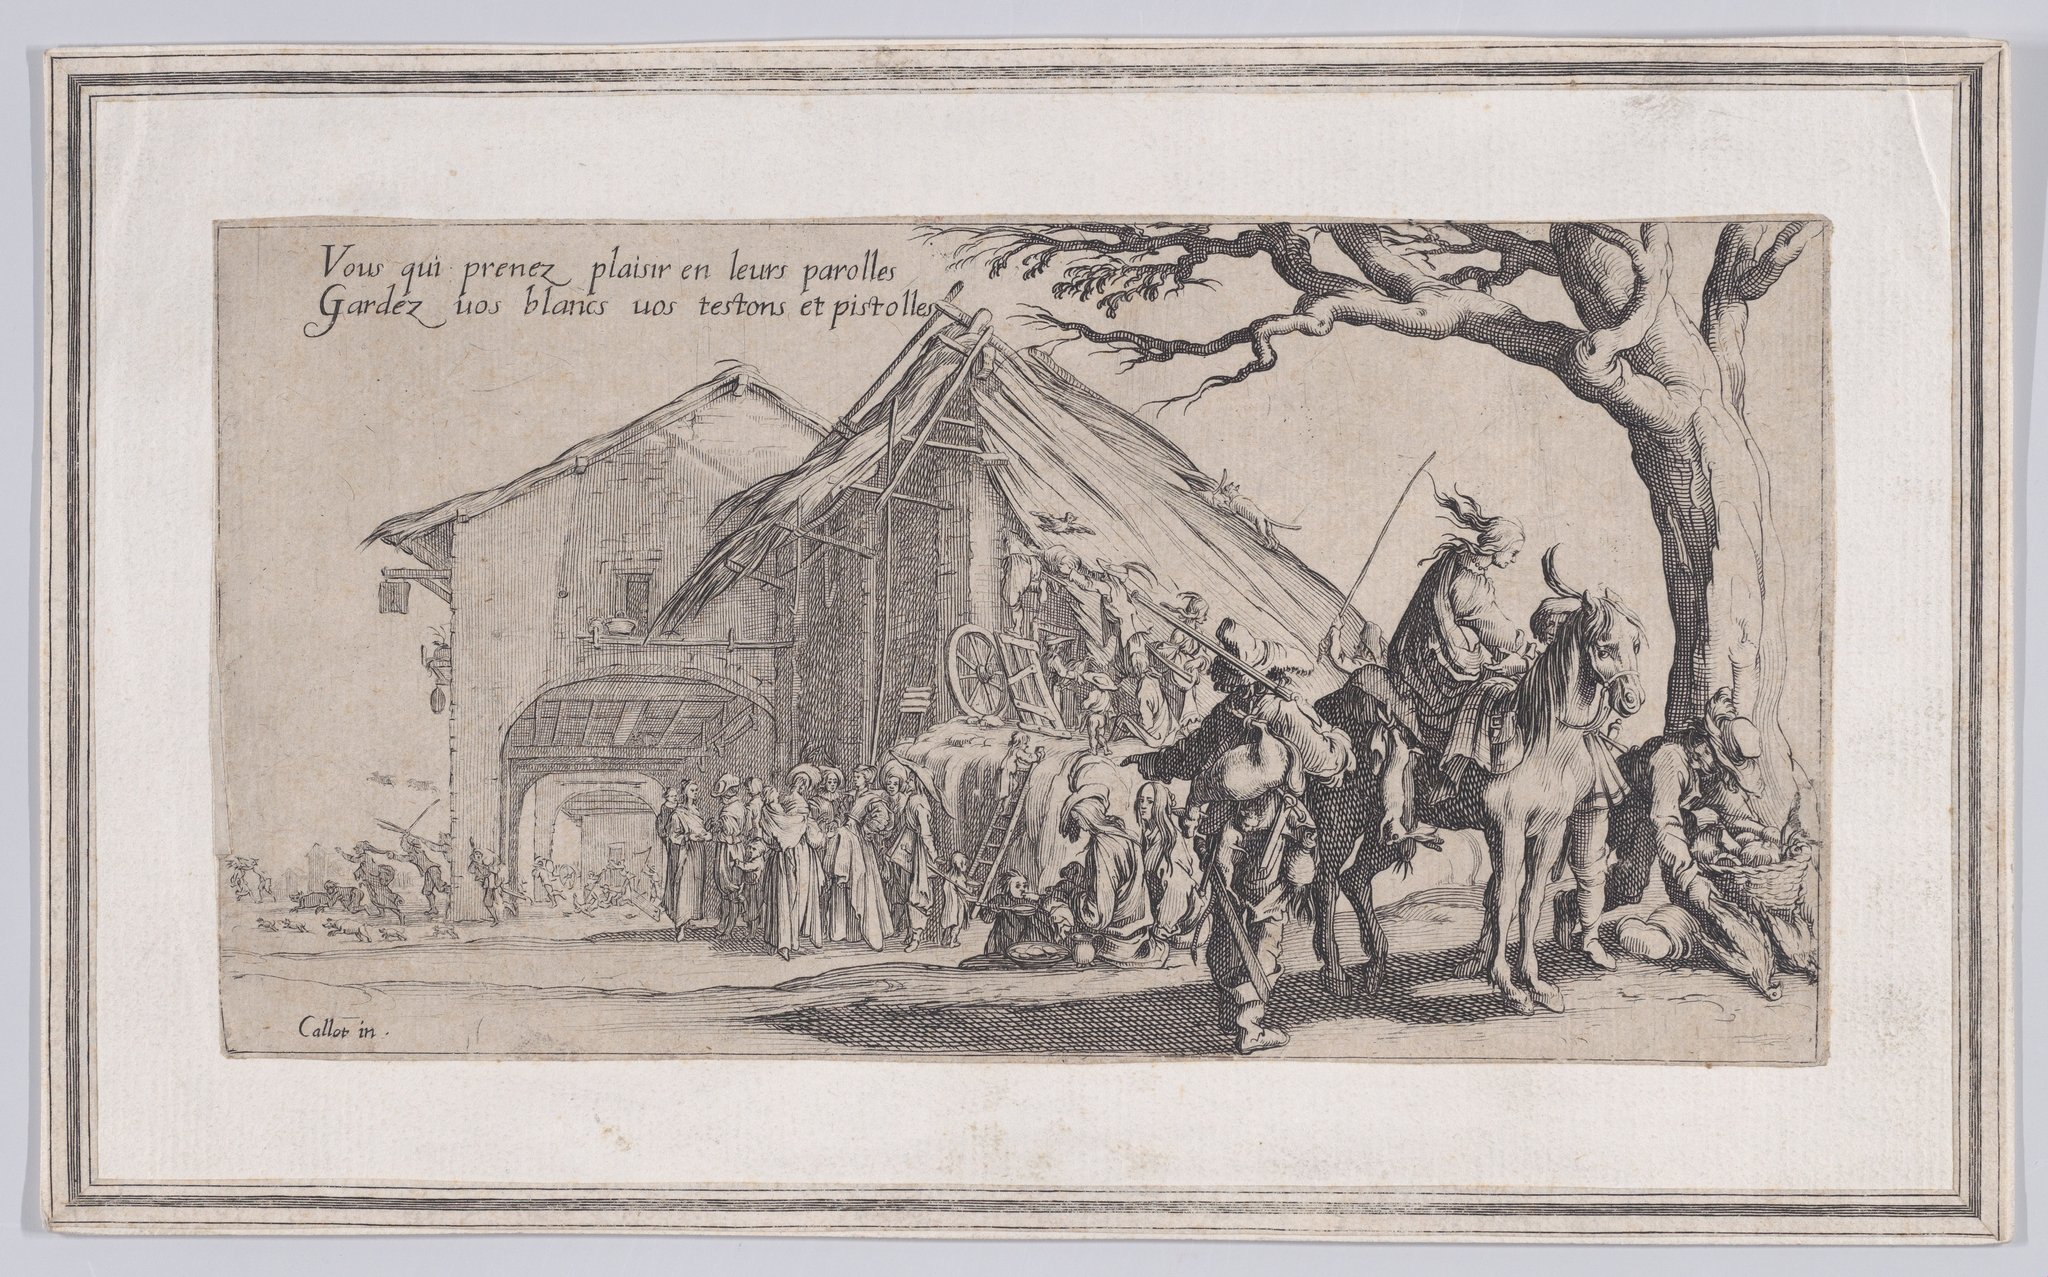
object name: print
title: Copy of La Halte des Bohémiens: Les Diseuses de Bonne Aventure (The Gypsy Stopover: The Fortune Tellers), from "Le Bohémiens..."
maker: Anonymous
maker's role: artist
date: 1601-1700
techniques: engraving, etching